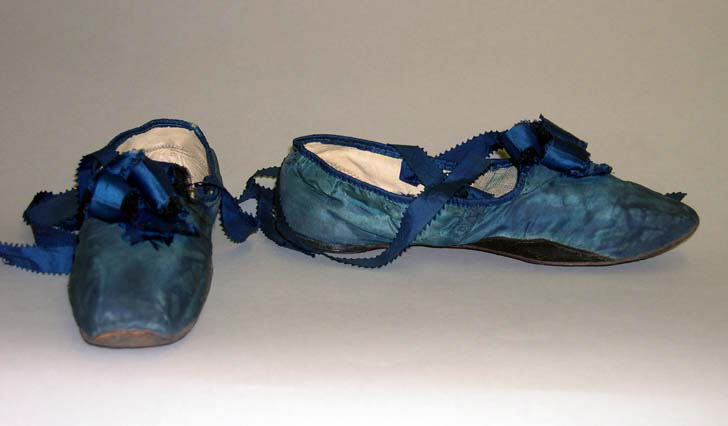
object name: shoe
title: Shoes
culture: american or european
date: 1801-1833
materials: silk